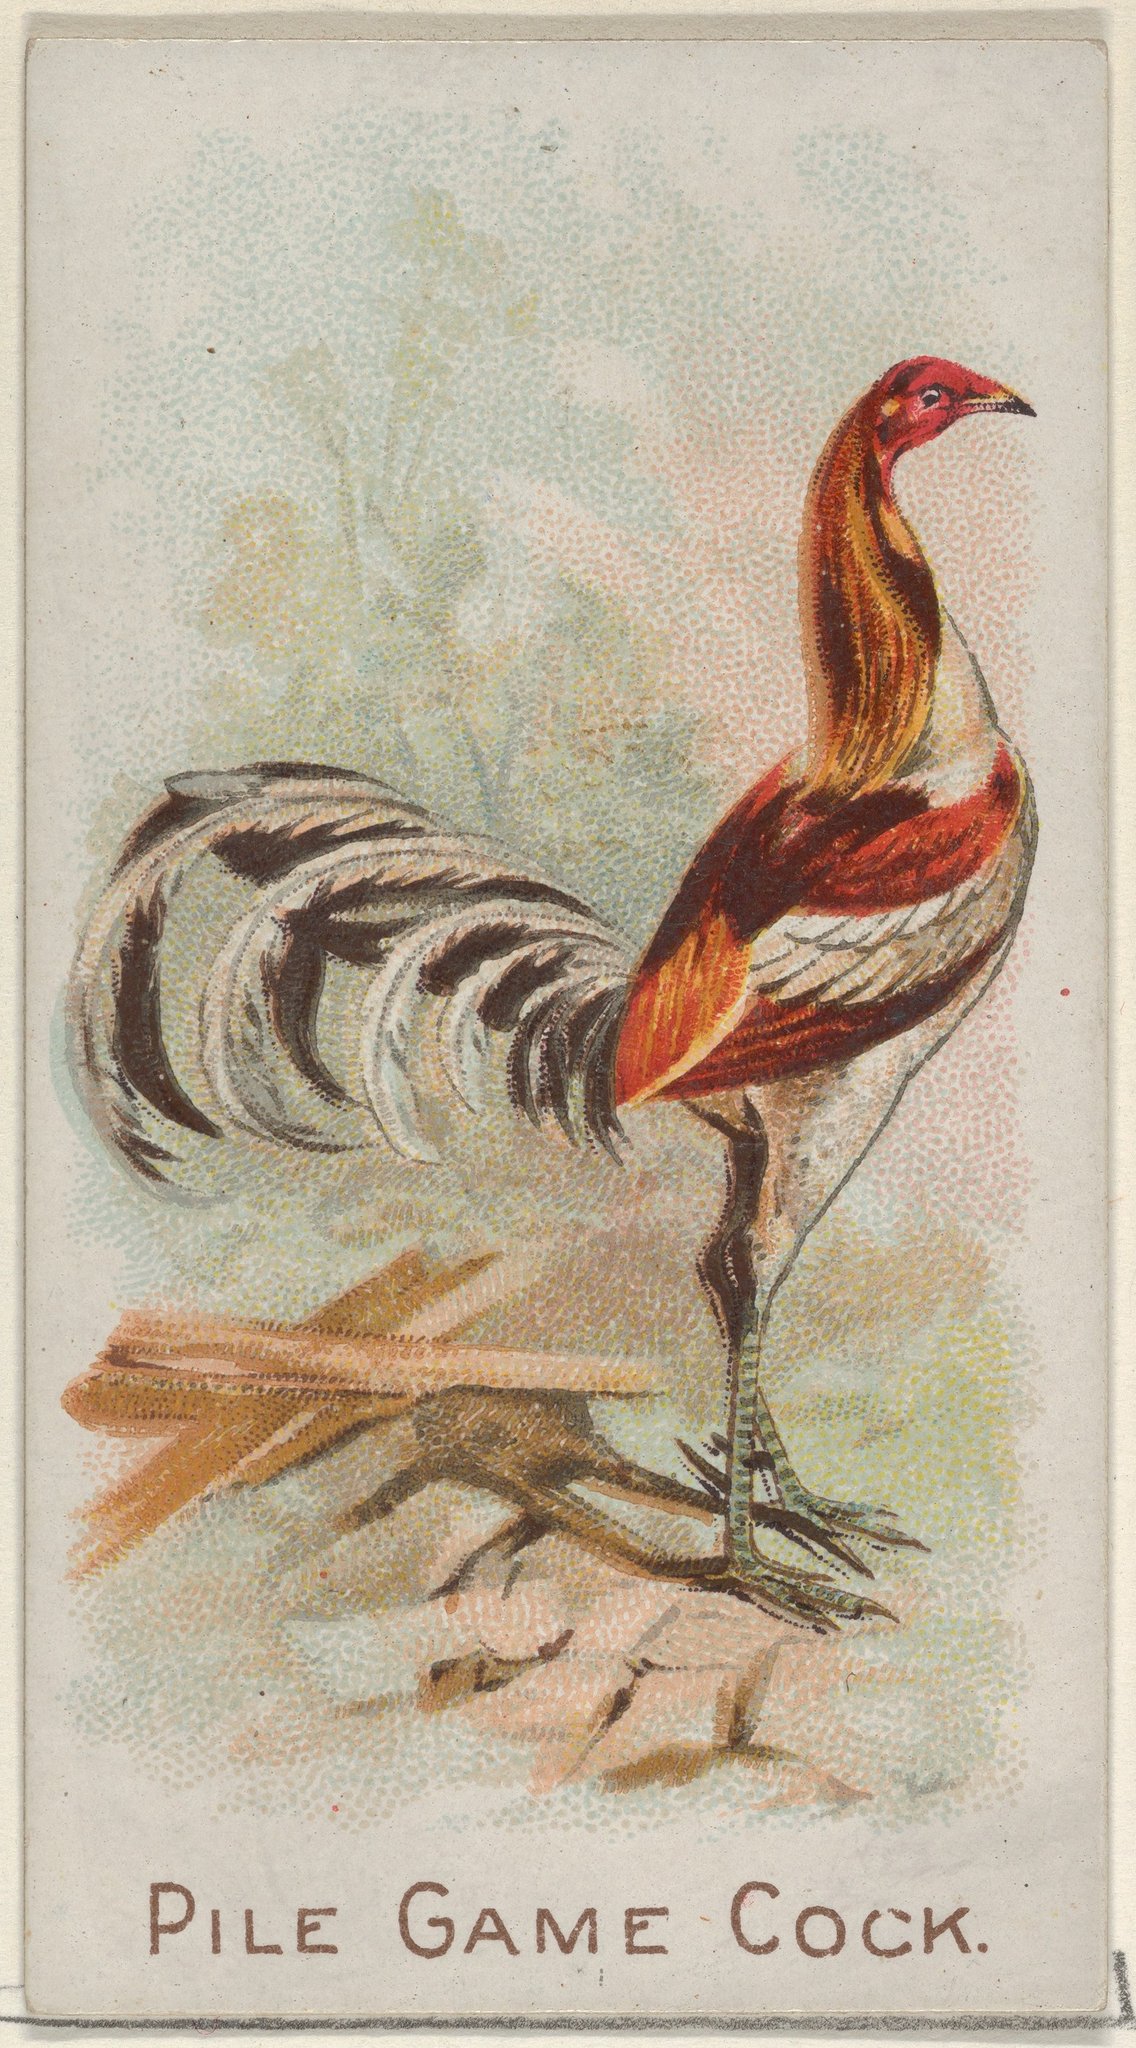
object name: print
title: Pile Game Cock, from the Prize and Game Chickens series (N20) for Allen & Ginter Cigarettes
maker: allen & ginter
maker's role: publisher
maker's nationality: american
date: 1891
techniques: color lithograph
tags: roosters